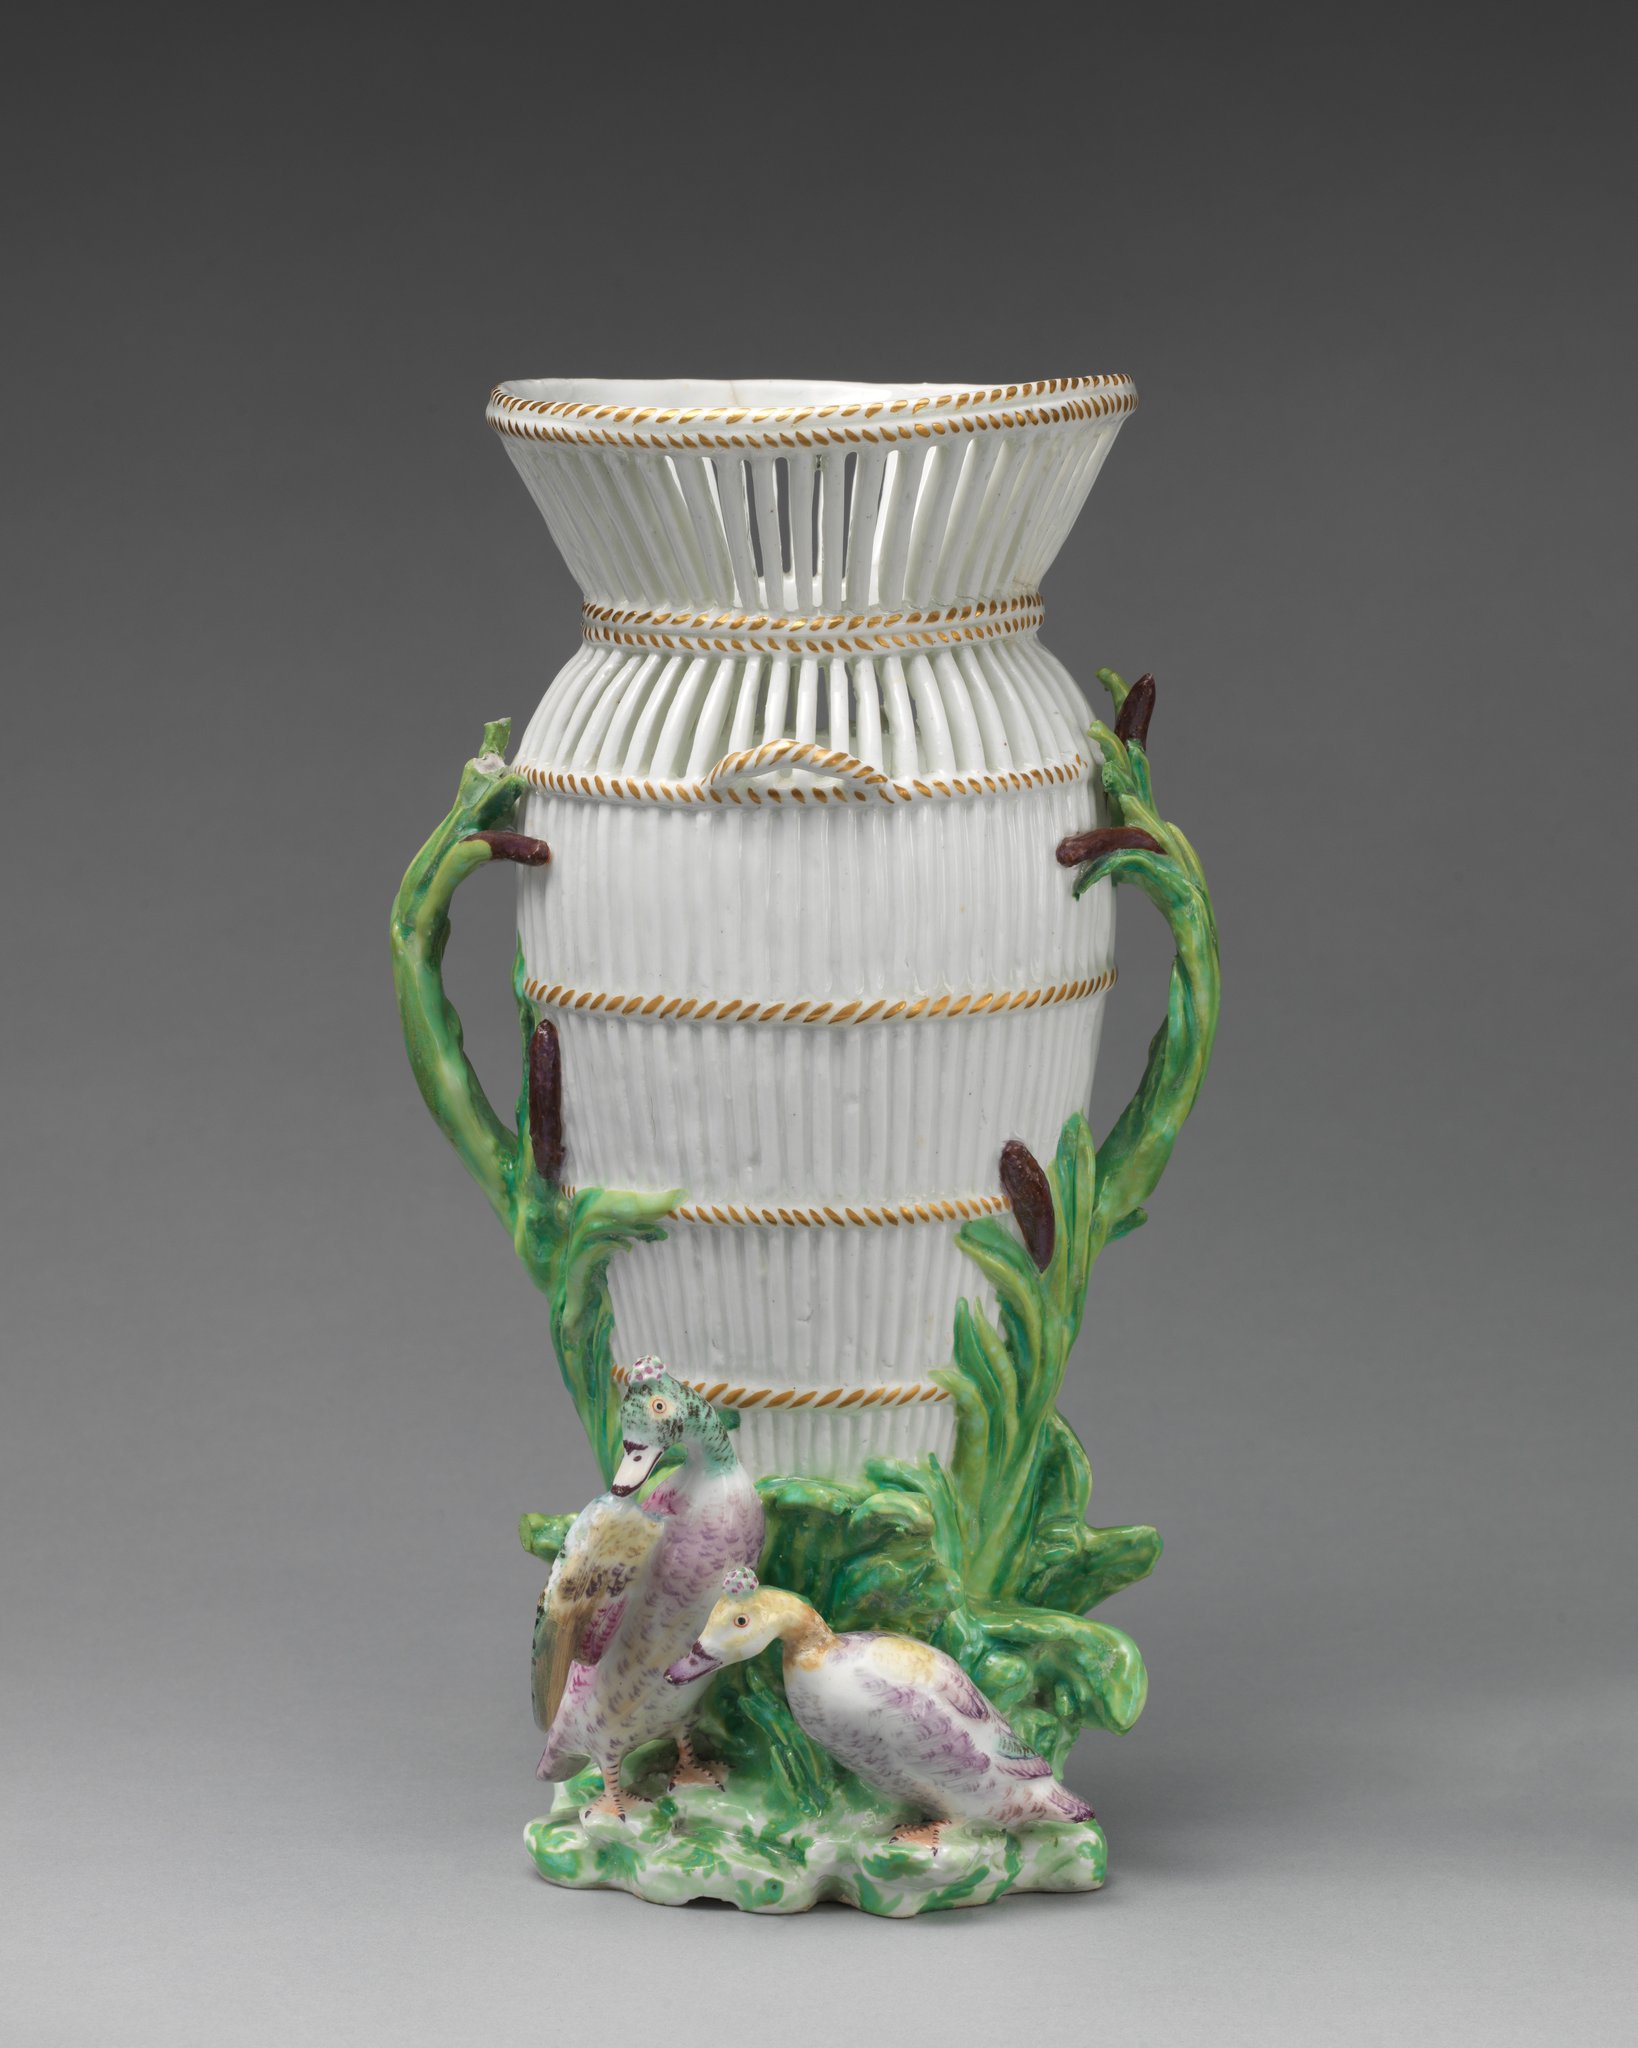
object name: vase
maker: chelsea porcelain manufactory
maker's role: factory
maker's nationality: british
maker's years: 1744-1784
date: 1756-1760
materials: soft paste porcelain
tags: ducks